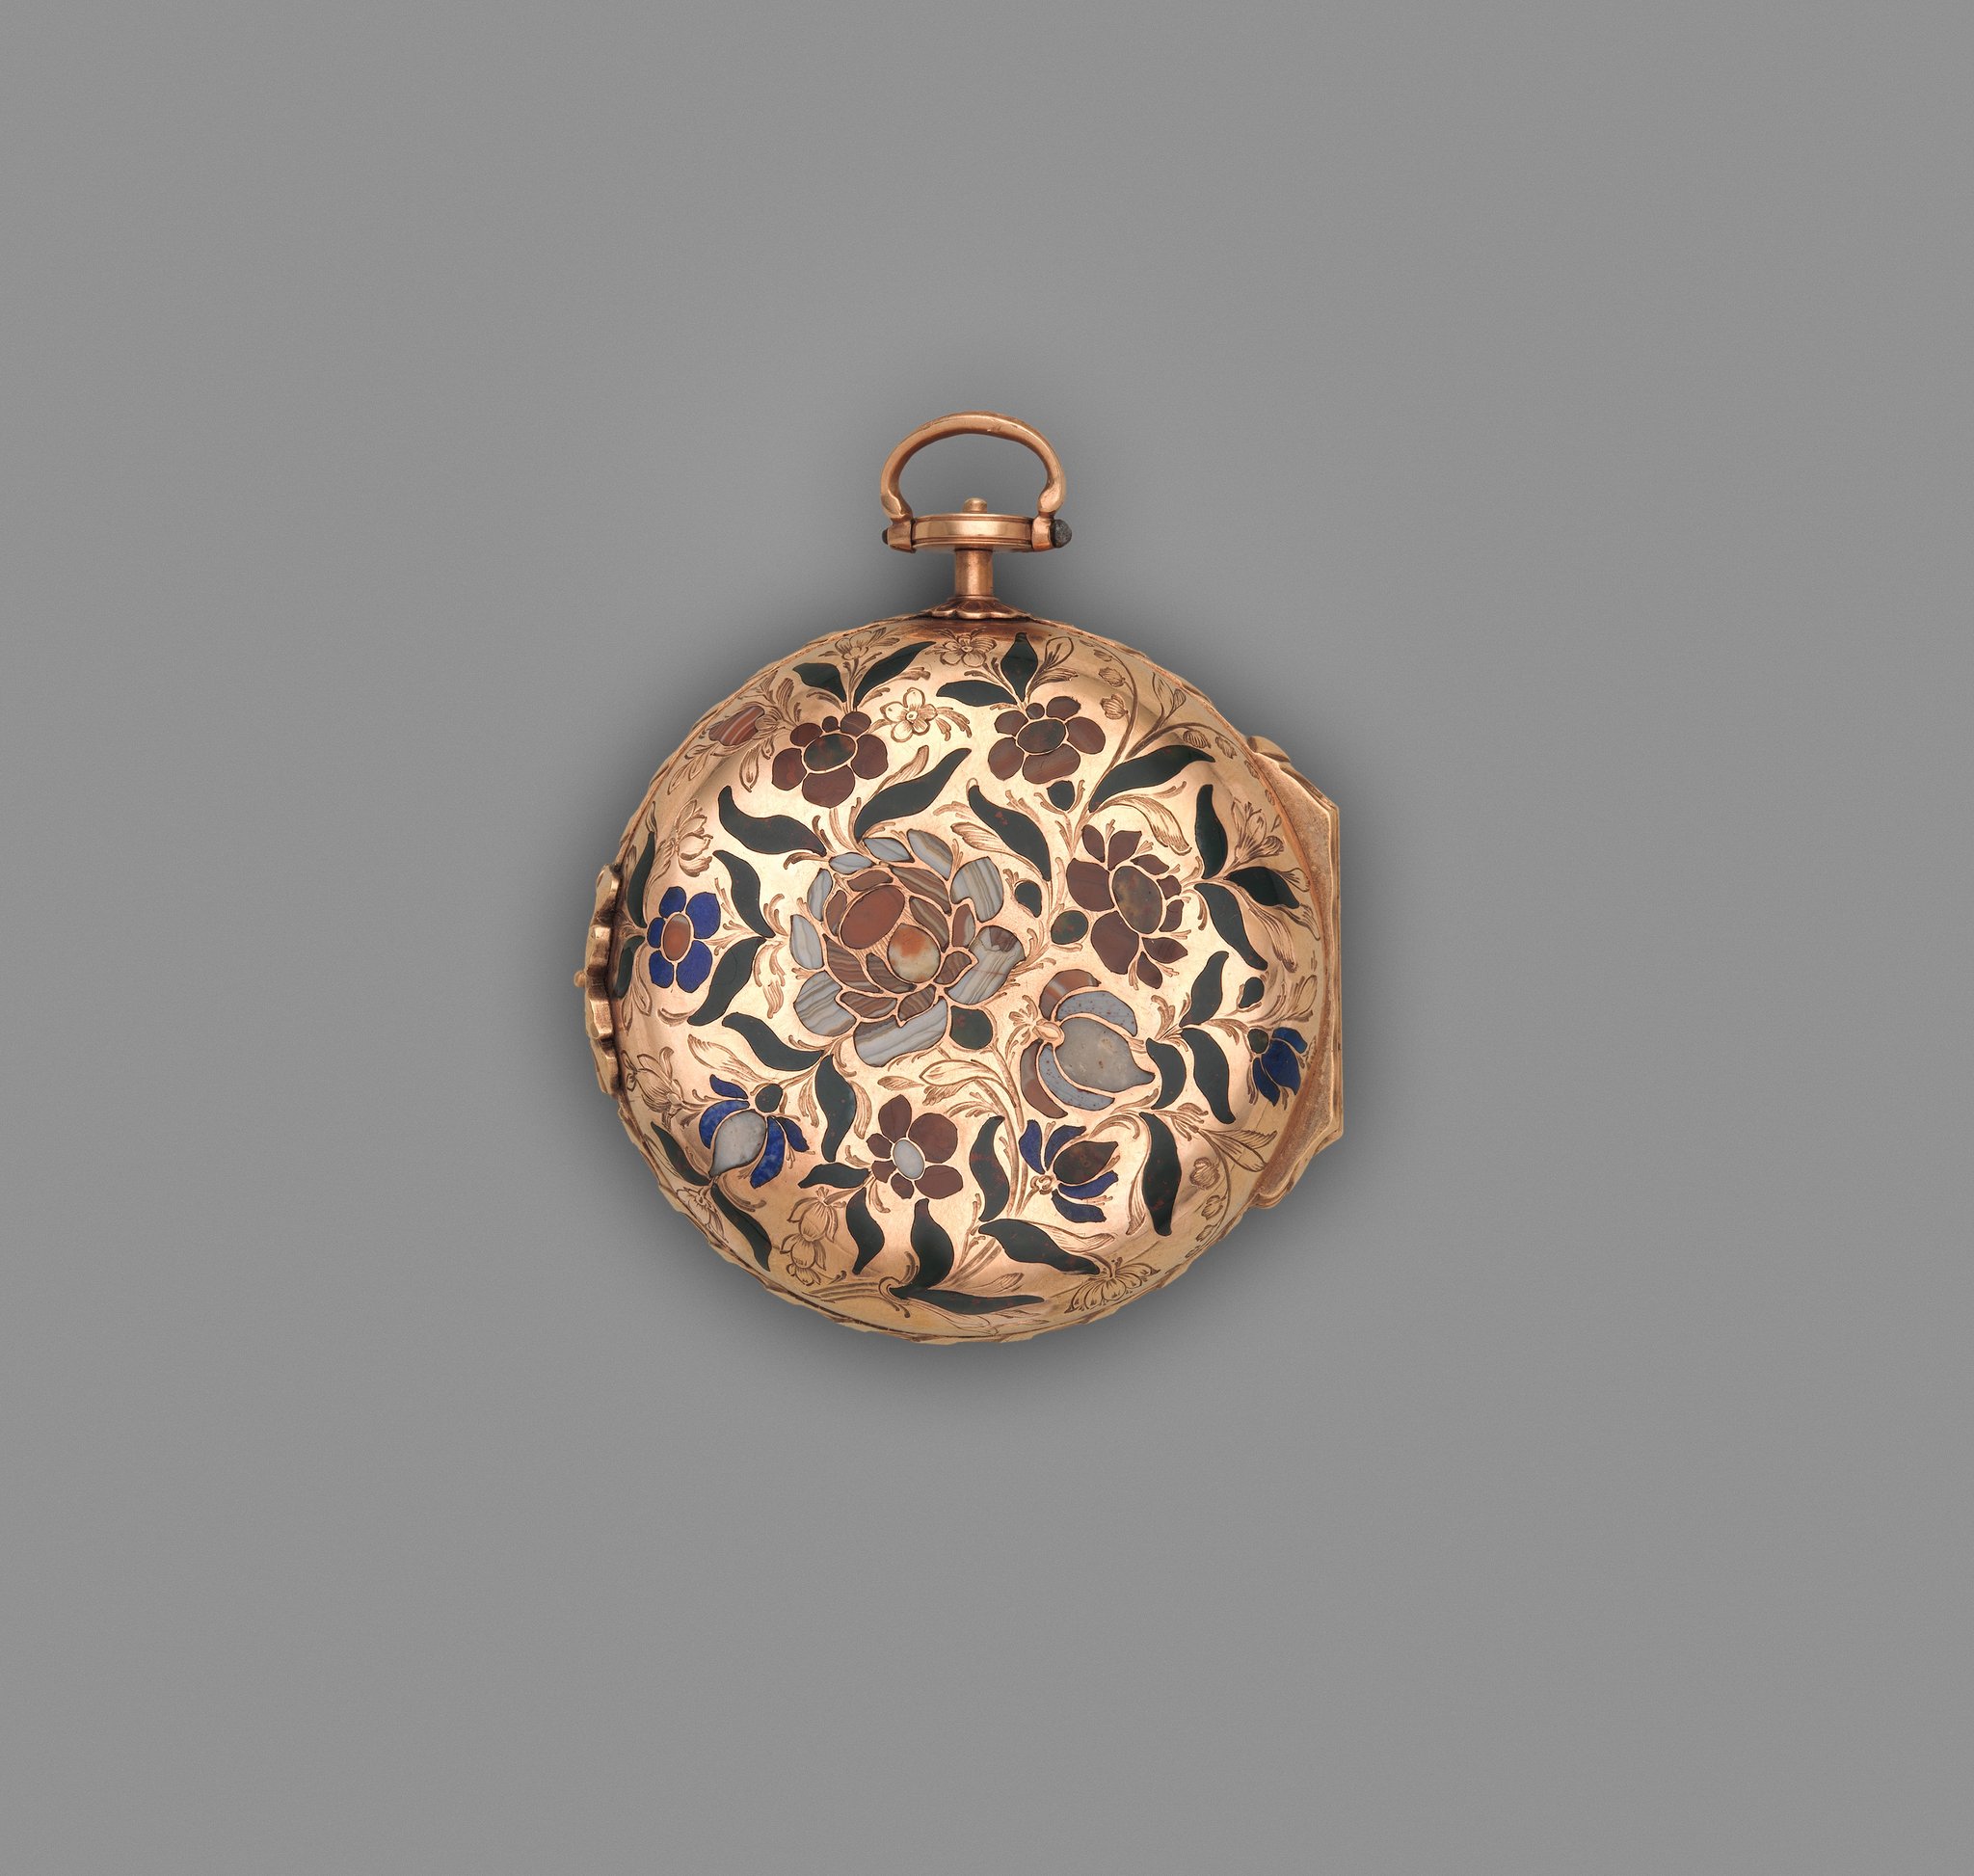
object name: watch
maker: christian gottlieb stiehl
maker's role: maker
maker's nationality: german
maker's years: 1708-1792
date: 1770-1780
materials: gold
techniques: inlay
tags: flowers,leaves